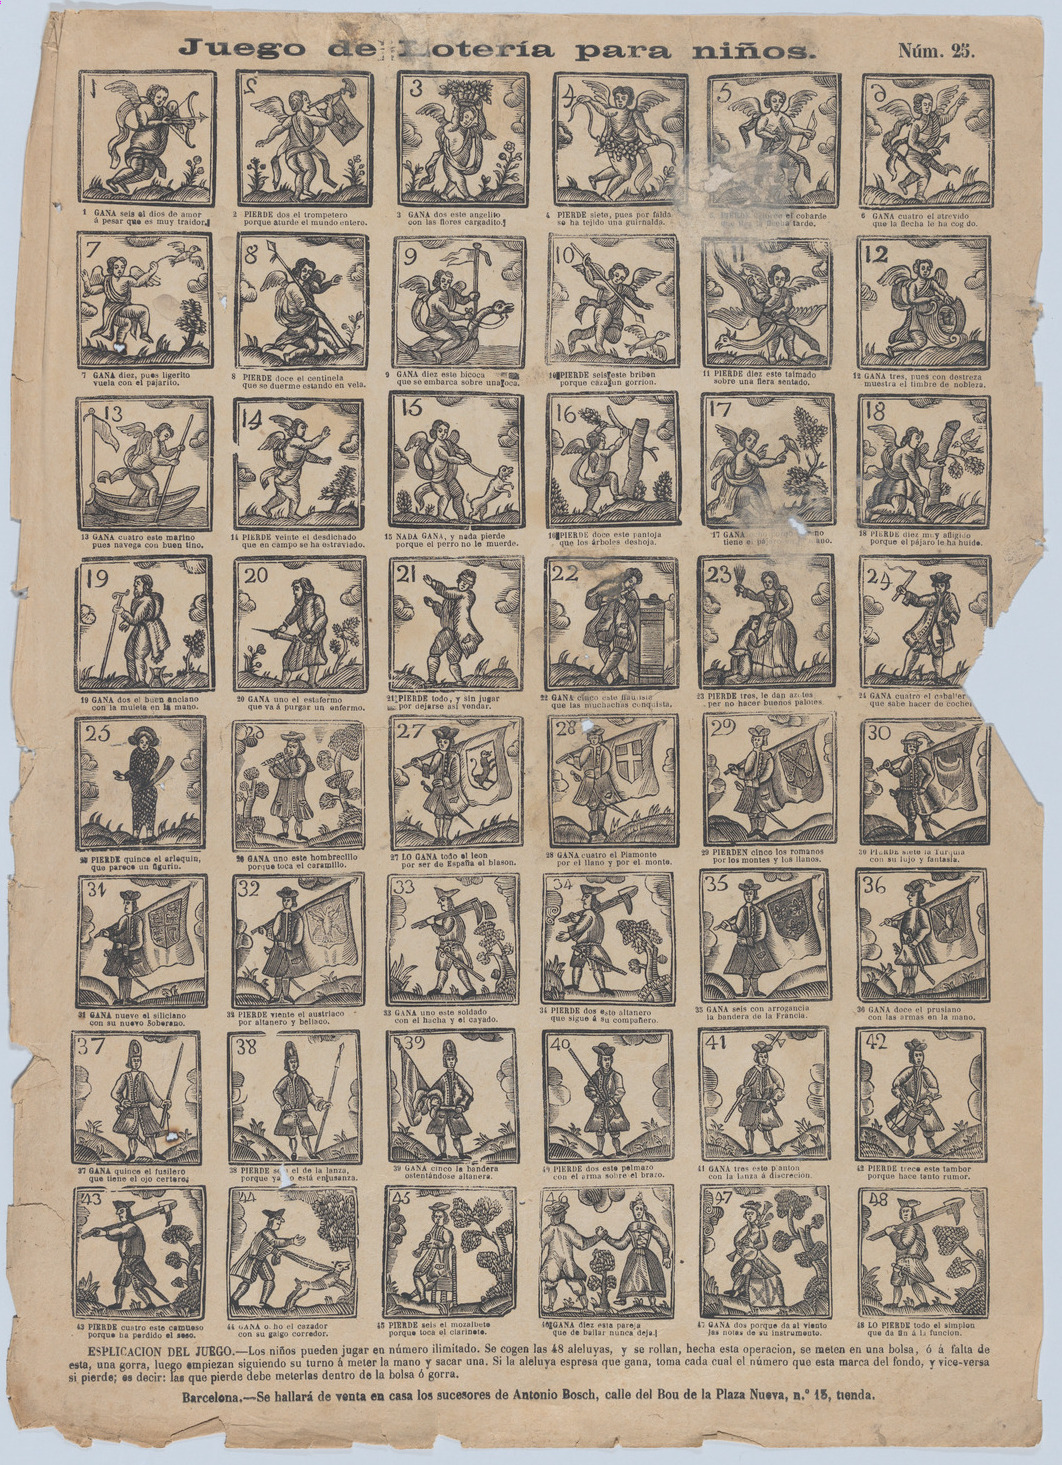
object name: print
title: Lottery game for children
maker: antonio bosch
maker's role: publisher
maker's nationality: spanish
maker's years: 1860-1880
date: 1860-1870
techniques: engraving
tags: games